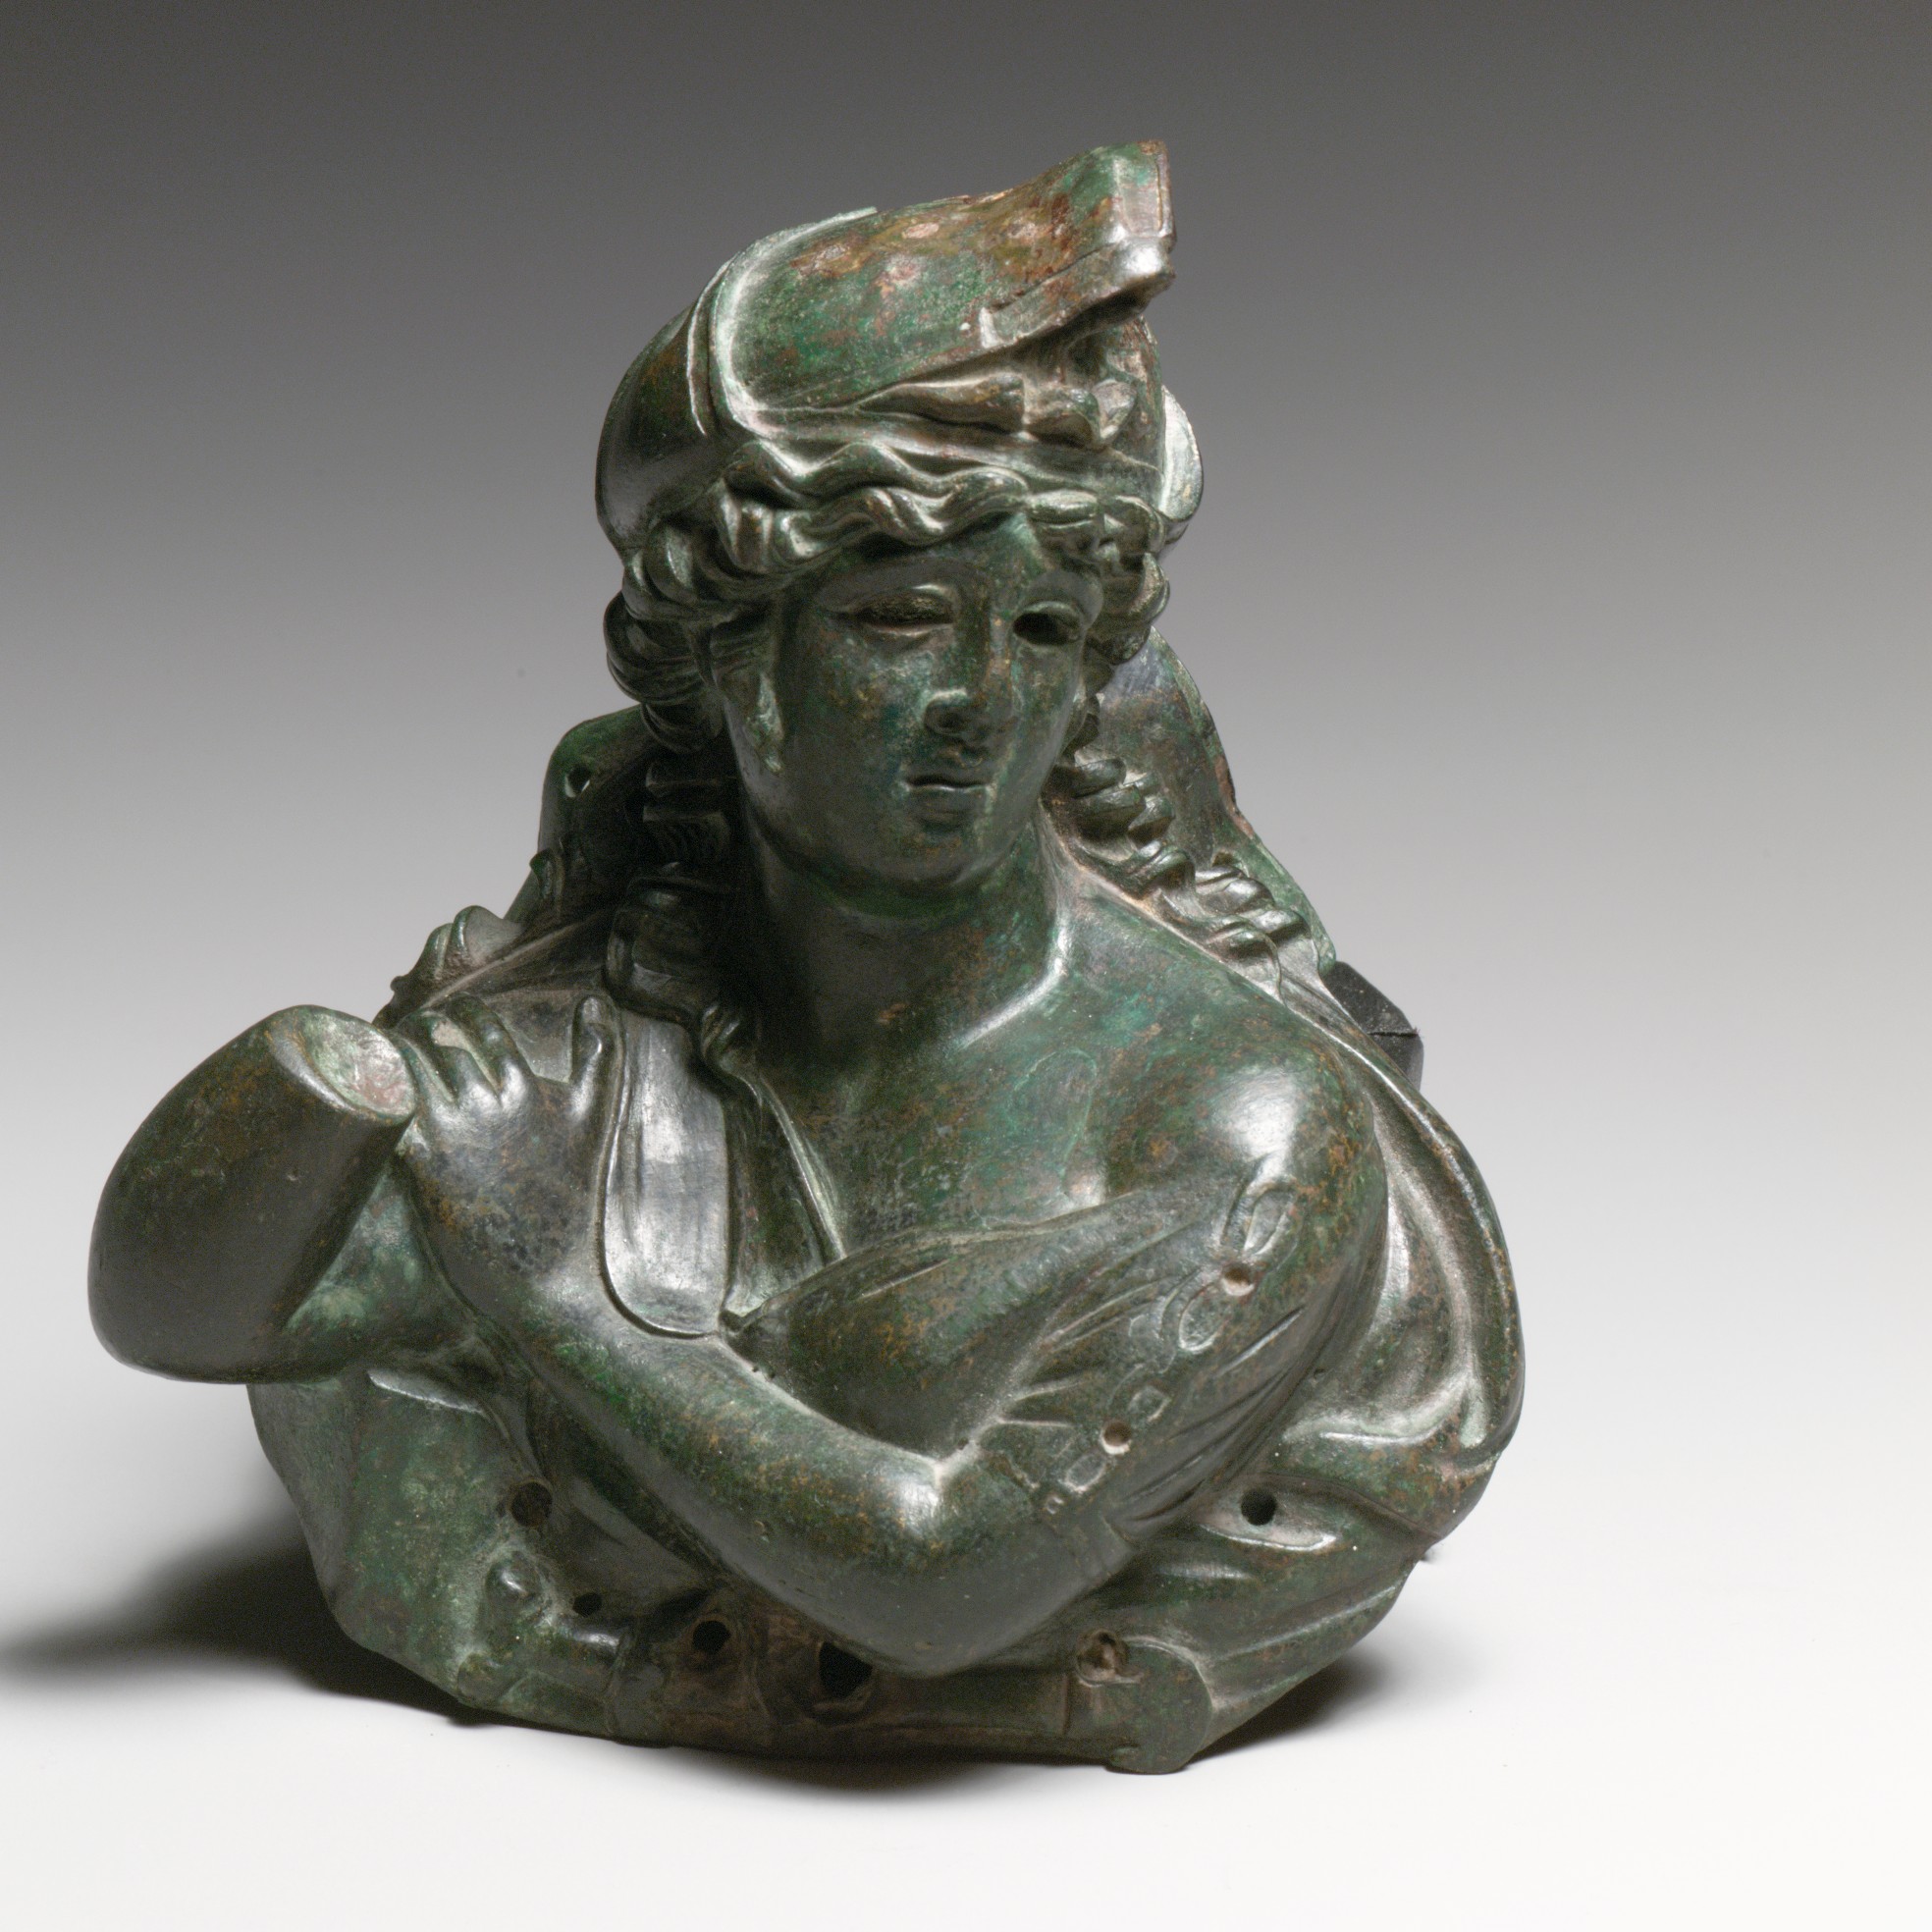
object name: bust of amazon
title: Bronze bust of an Amazon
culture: roman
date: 1-100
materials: bronze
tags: portraits,women,amazons